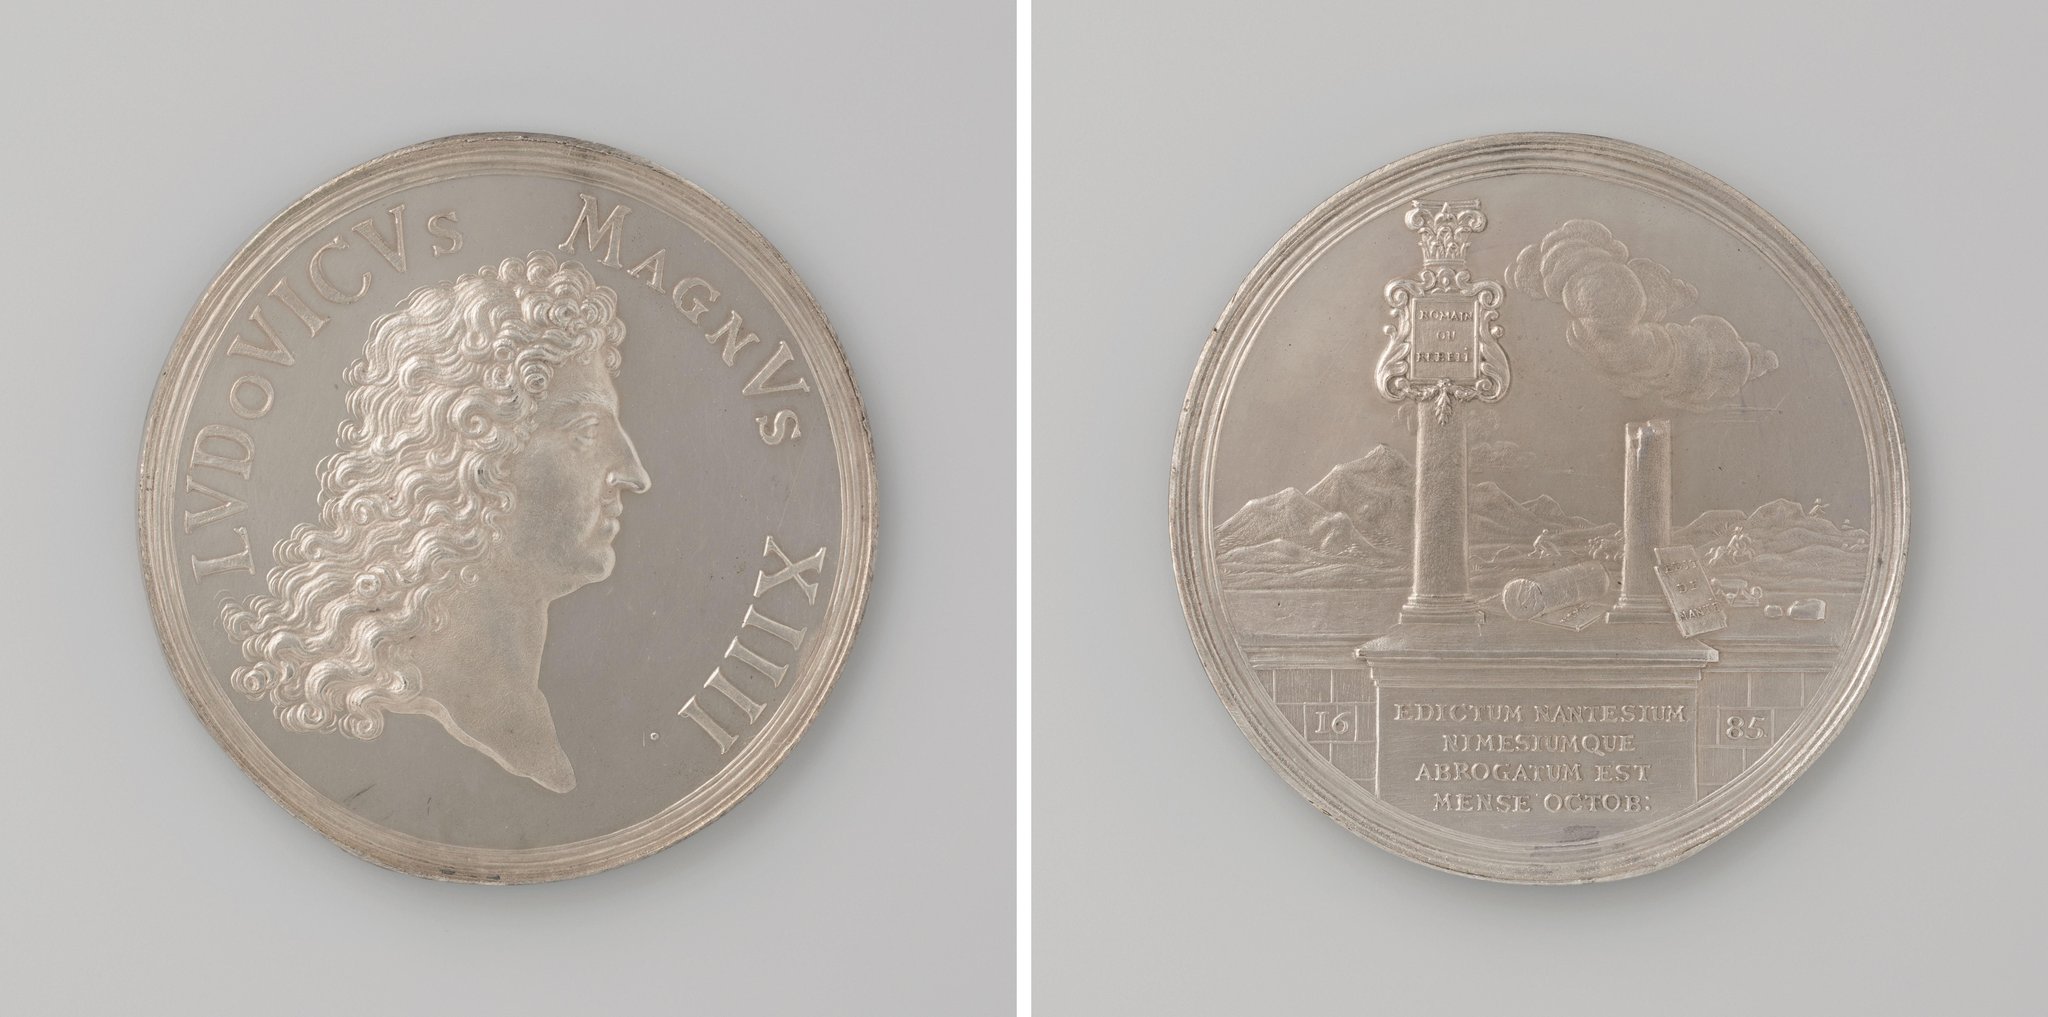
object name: history medal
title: Herroeping van het edict van Nantes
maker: jan smeltzing (i)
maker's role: modelleur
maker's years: 1656-1693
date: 1685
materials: silver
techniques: striking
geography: leiden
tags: lodewijk xiv (koning van frankrijk), france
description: Zilveren penning. Voorzijde: borststsuk man binnen omschrift. Keerzijde: omver geworpen en overeind staande zuil boven opschrift.